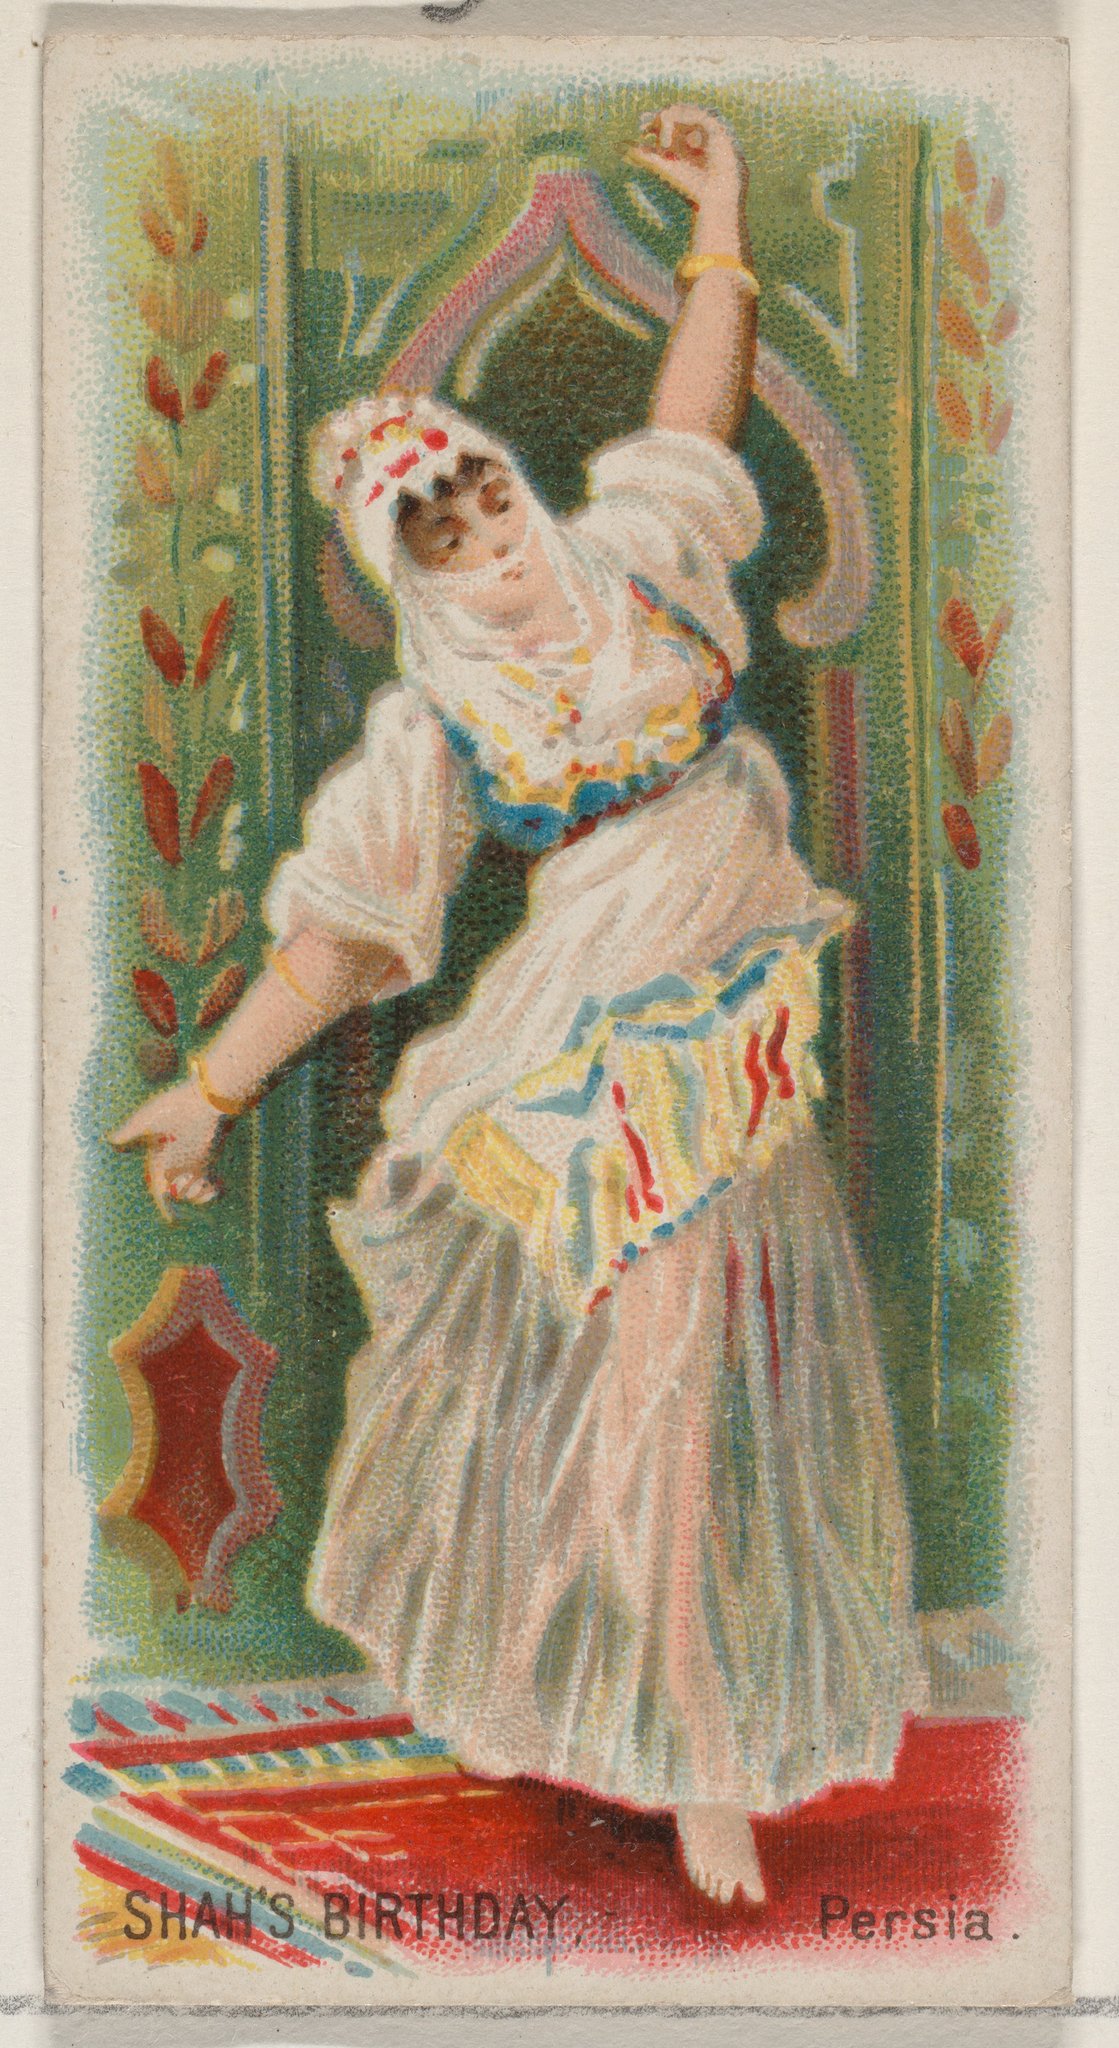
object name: print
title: Shah's Birthday, Persia, from the Holidays series (N80) for Duke brand cigarettes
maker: w. duke, sons & co.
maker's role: publisher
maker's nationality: american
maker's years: 1870-1920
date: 1890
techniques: color lithograph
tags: women